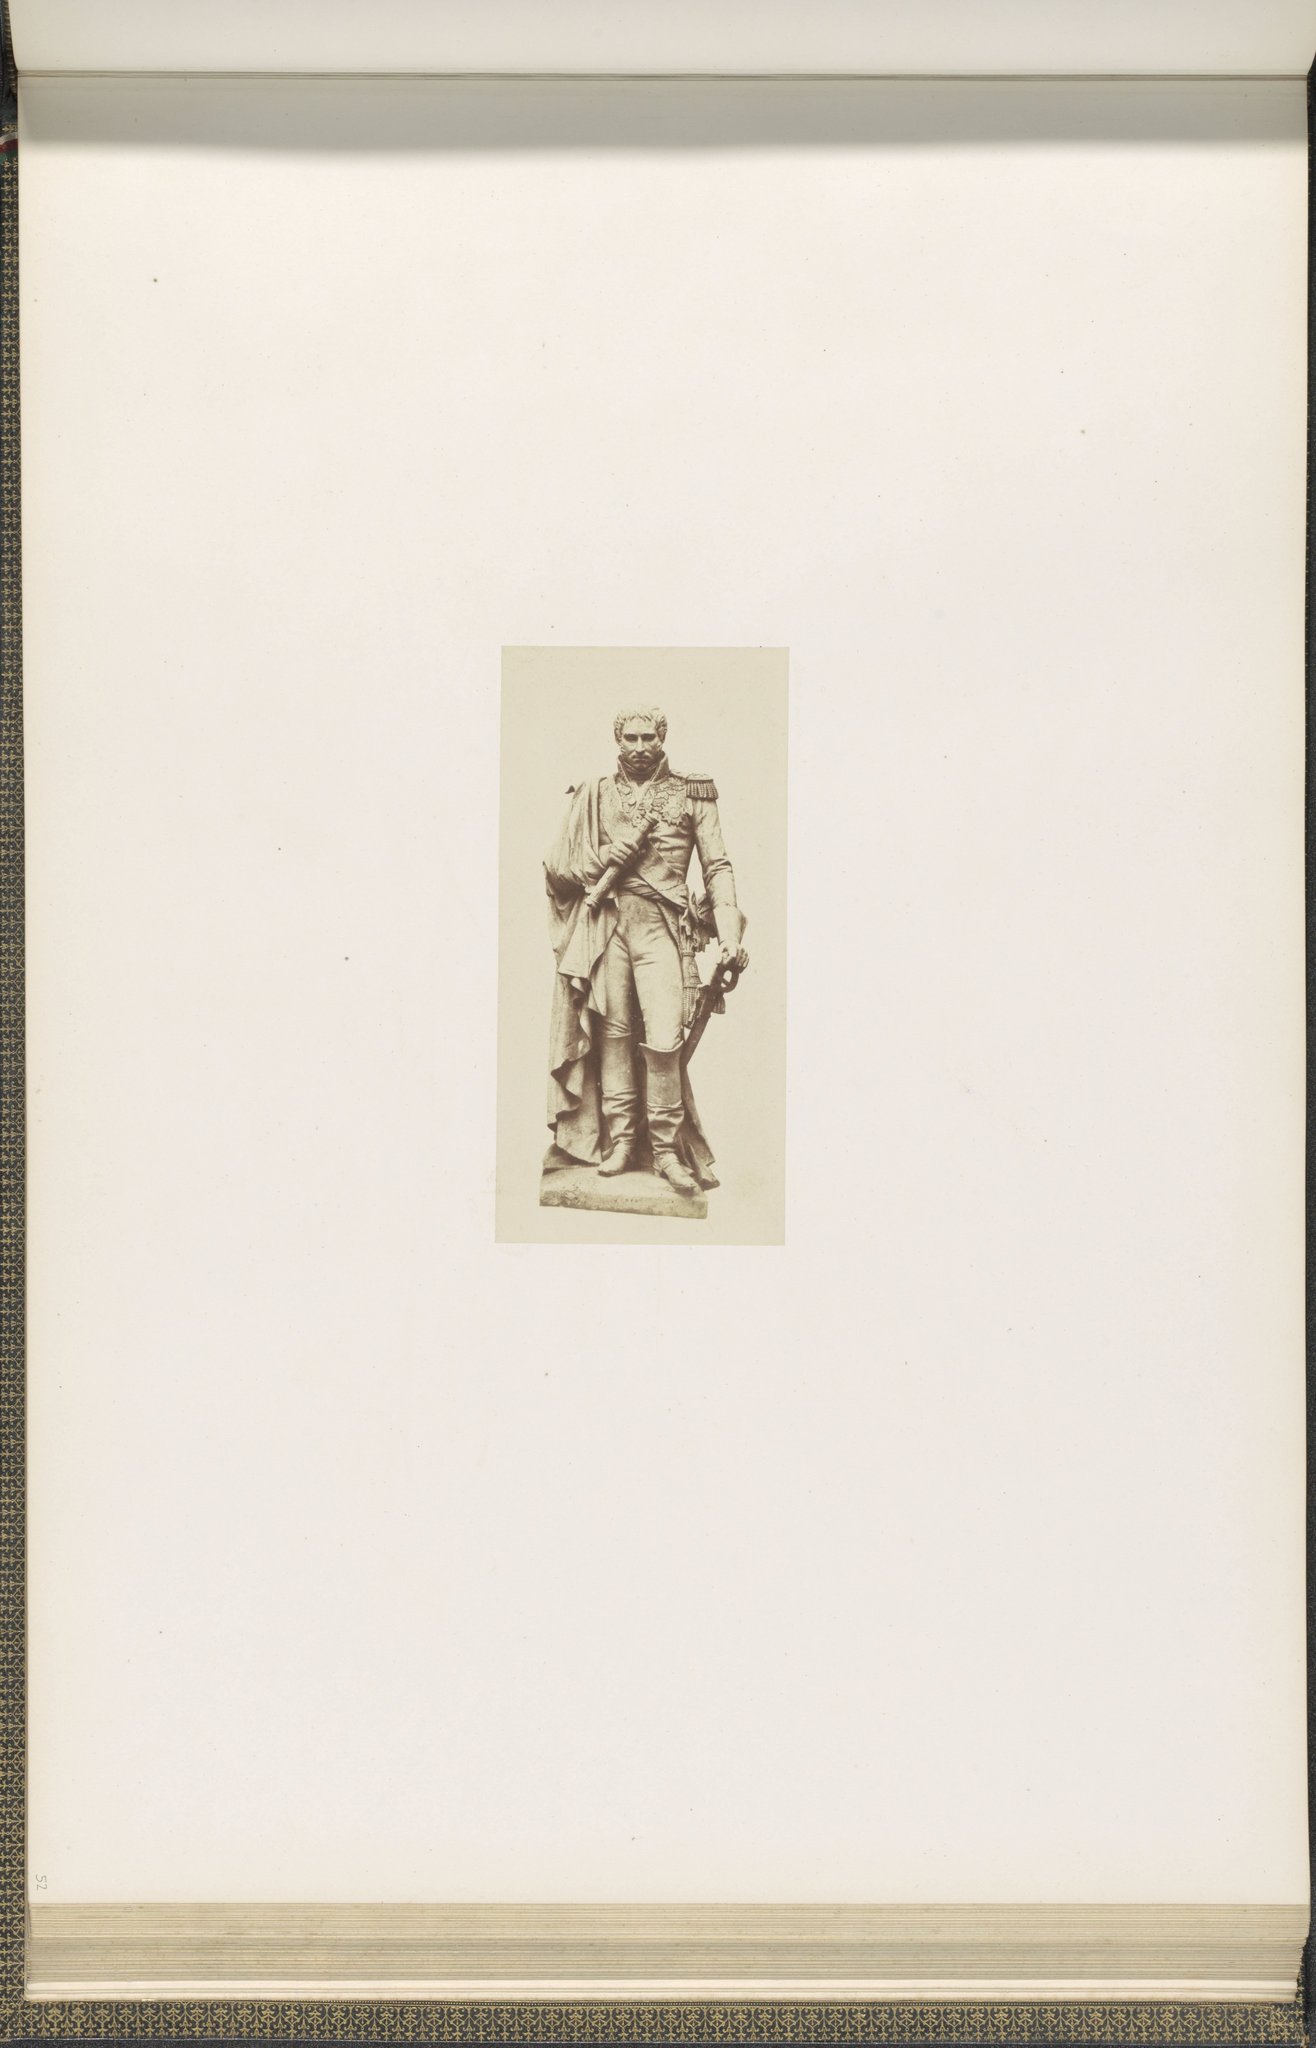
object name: album leaf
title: Gipsmodel voor beeldhouwwerk op het Palais du Louvre: "Masséna" door Célestin Anatole Calmels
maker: édouard denis baldus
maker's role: fotograaf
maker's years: 1813-1889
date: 1855-1857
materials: paper, photographic support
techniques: salted paper print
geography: paris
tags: piece of sculpture, reproduction of a piece of sculpture, permanent exhibition, museum, paris, tuileries palace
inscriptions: number: ‘945’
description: Onderdeel van Réunion des Tuileries au Louvre 1852-1857, album 4.